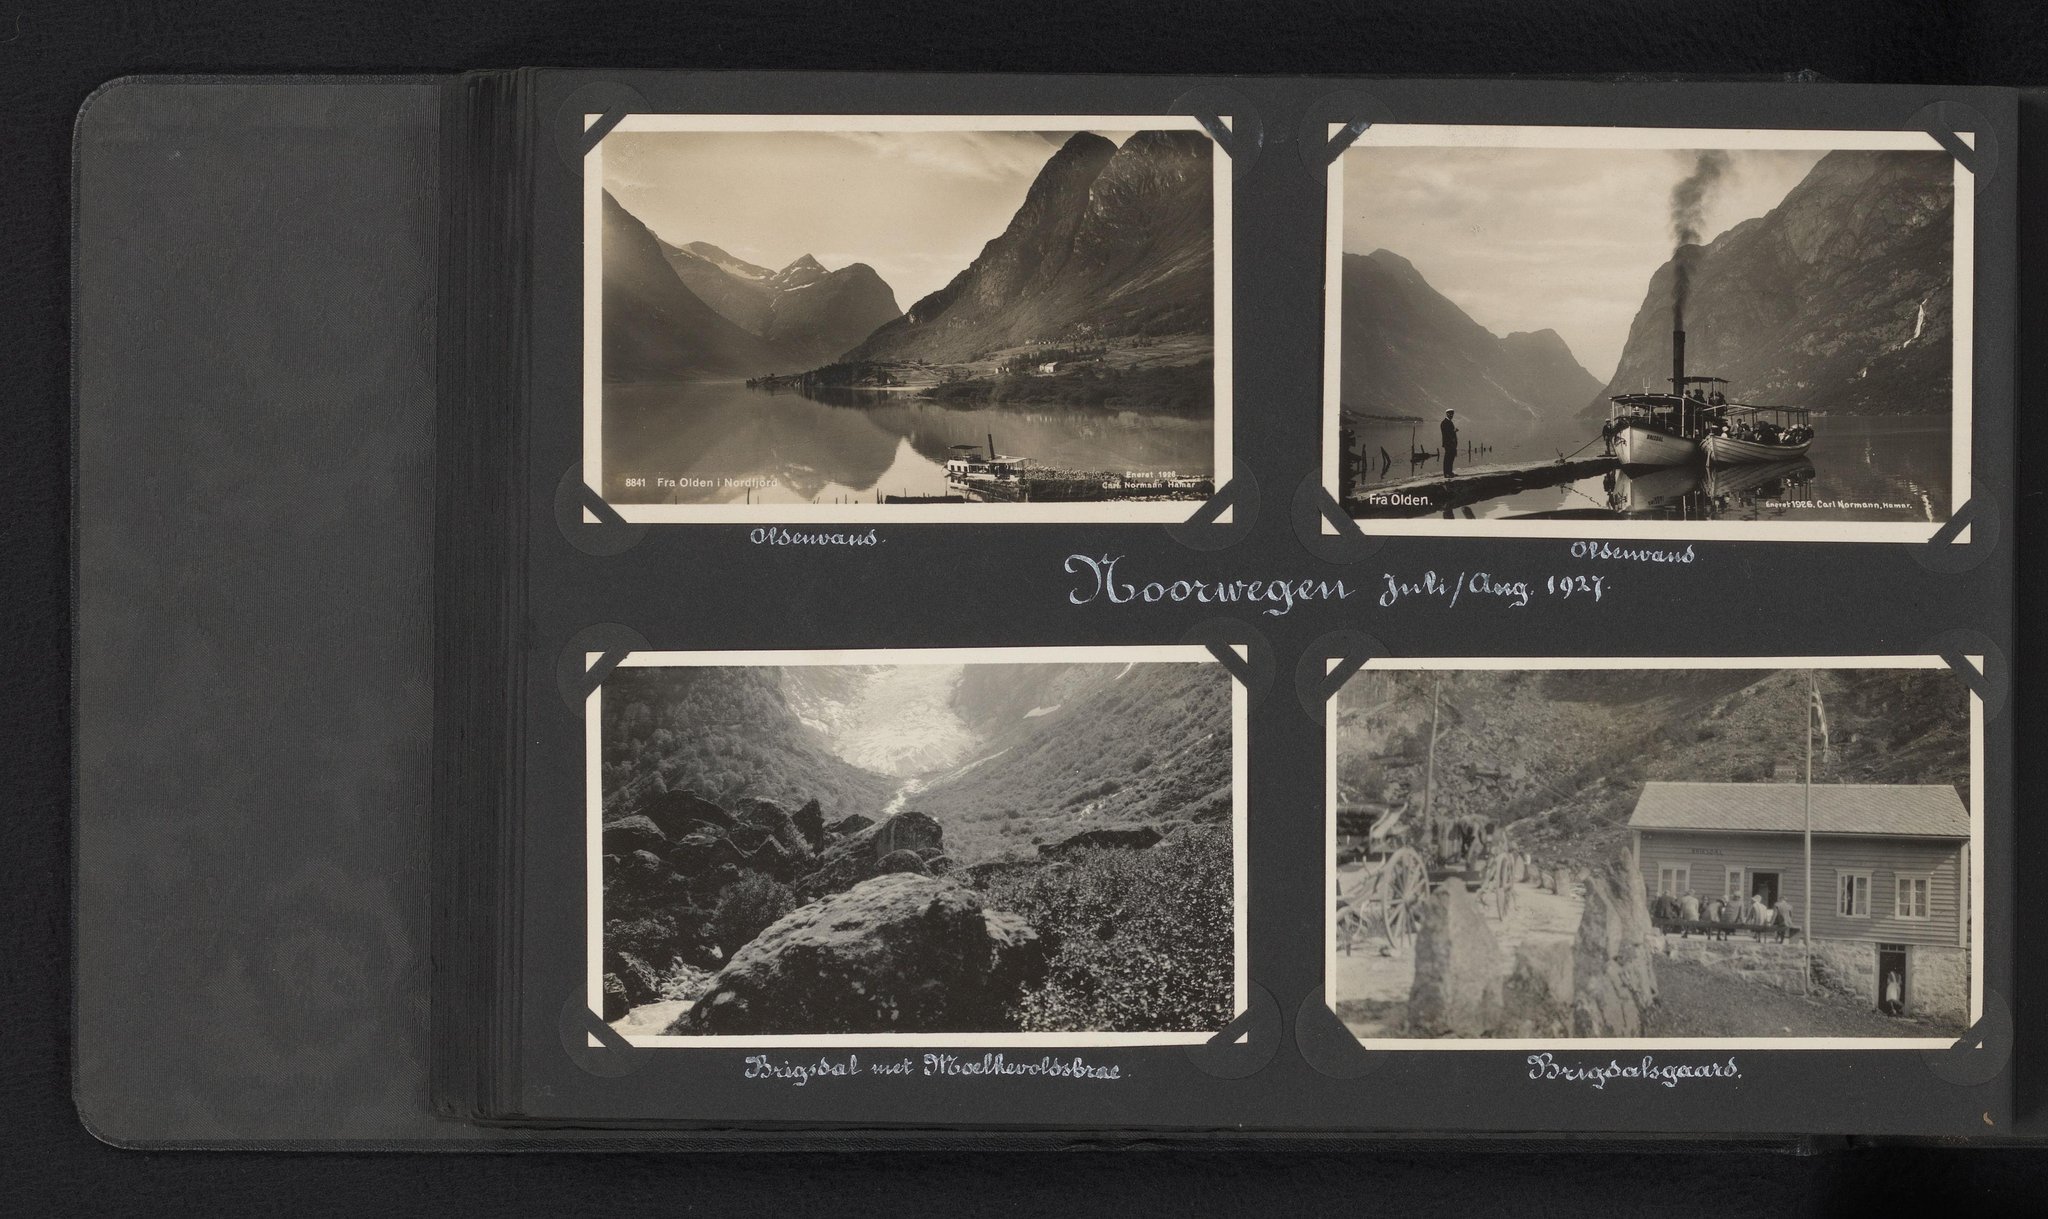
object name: ansichtkaart, prentbriefkaart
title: Noorwegen Juli/Aug. 1927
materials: paper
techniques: gelatin silver print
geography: norway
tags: fjord, sea loch, mountains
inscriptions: inscription: ‘Brigdalsgaard’, inscription: ‘Brigsdal met Moelkevolsbrae’, inscription: ‘Oldenvand’, inscription: ‘Oldenvand’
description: Deze foto's maken deel uit van een album.